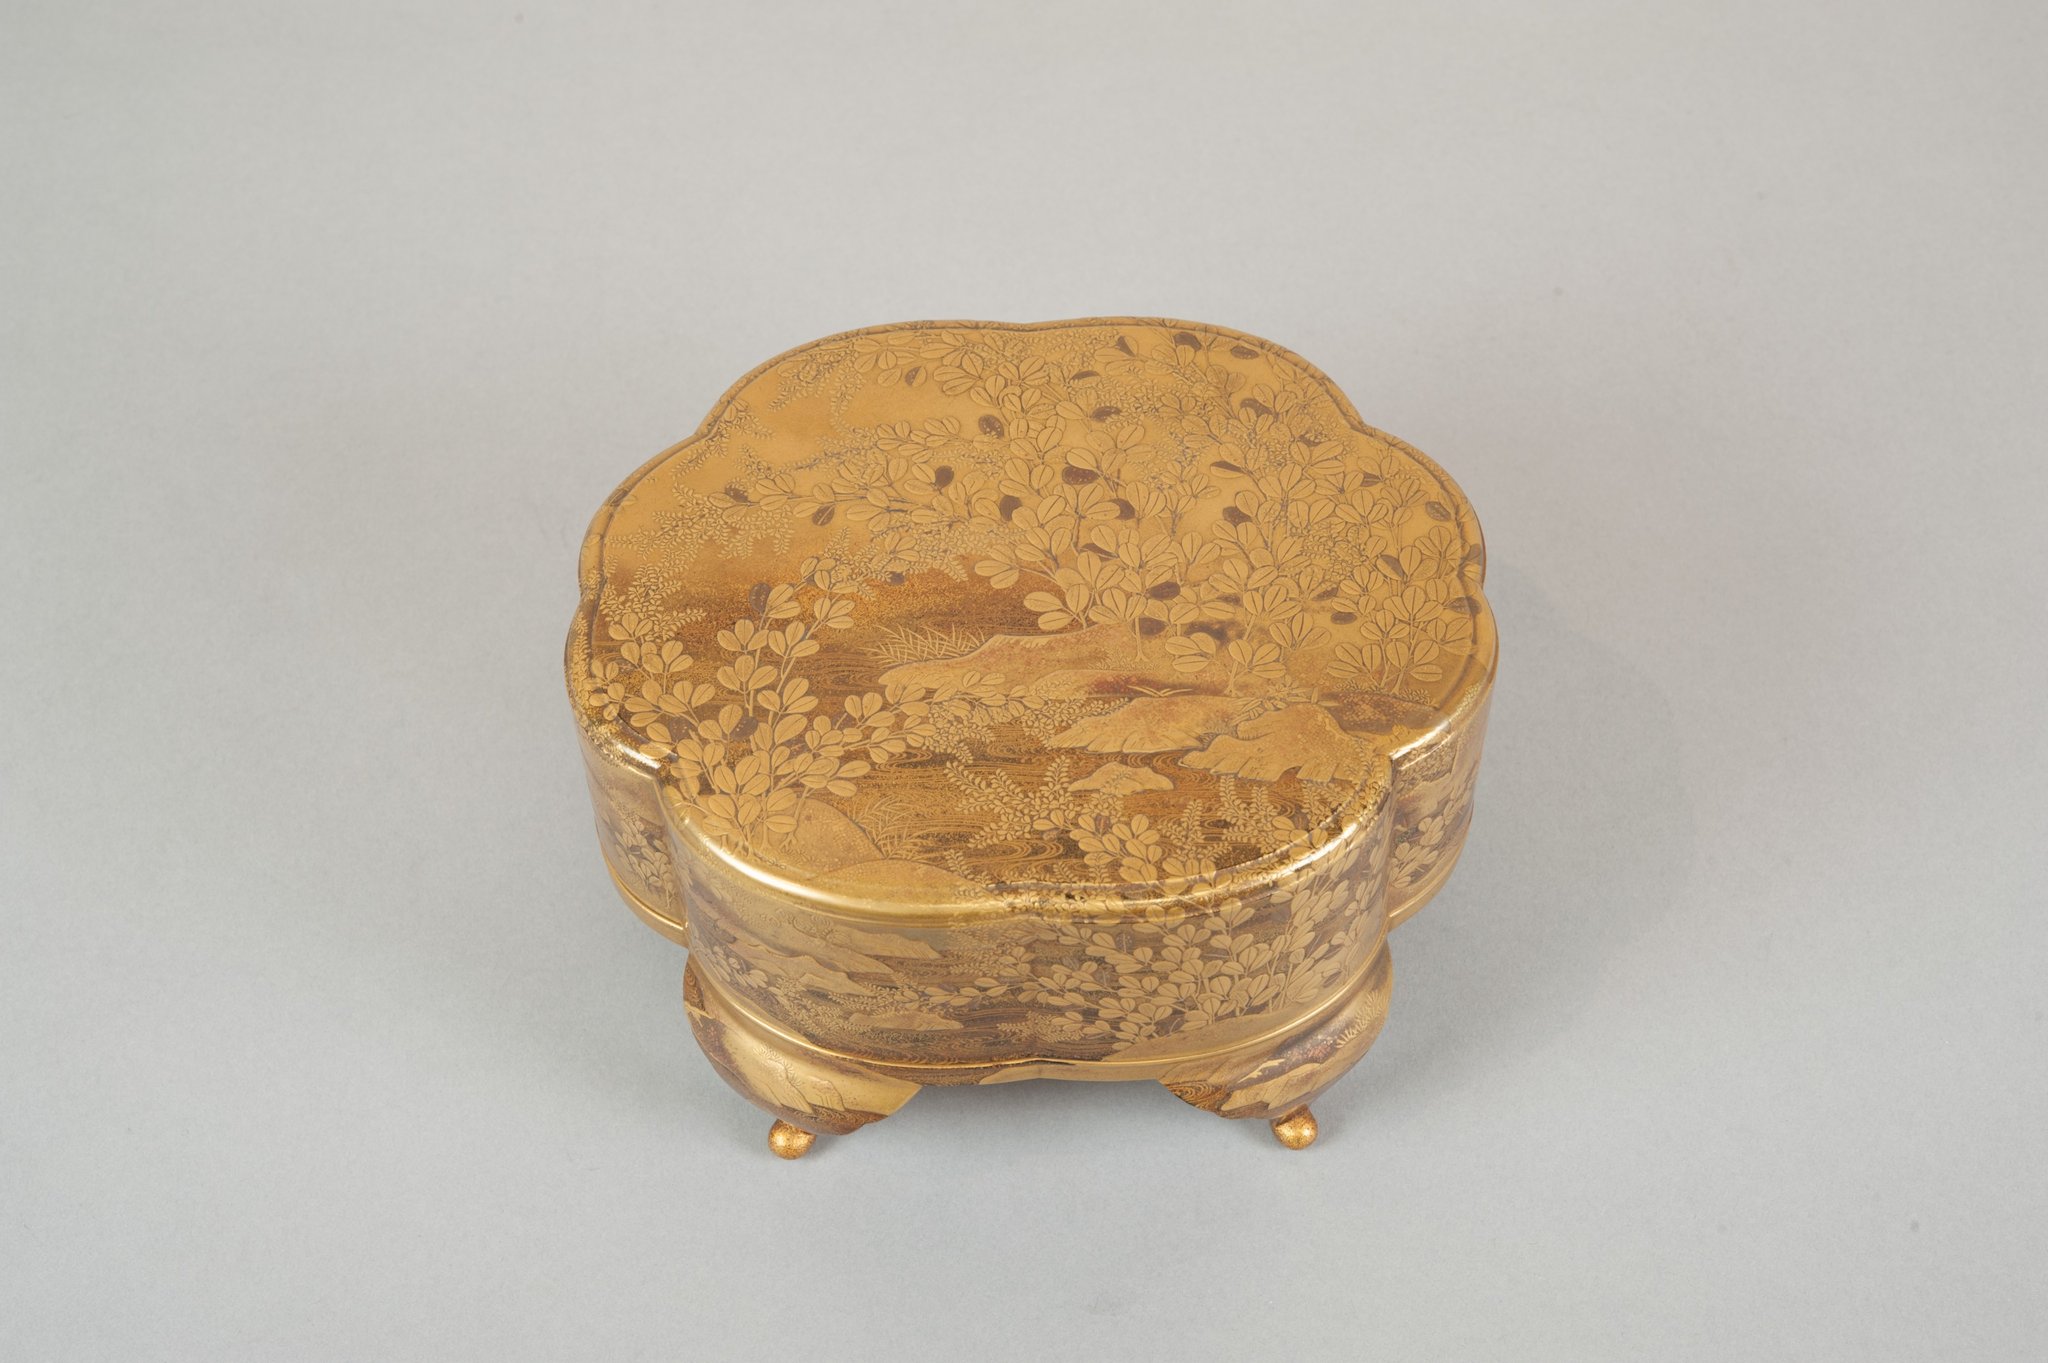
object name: legged box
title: Legged Box with Design of Bush Clover along a Stream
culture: japanese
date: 1701-1800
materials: gold, lacquer, silver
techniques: maki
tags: trees